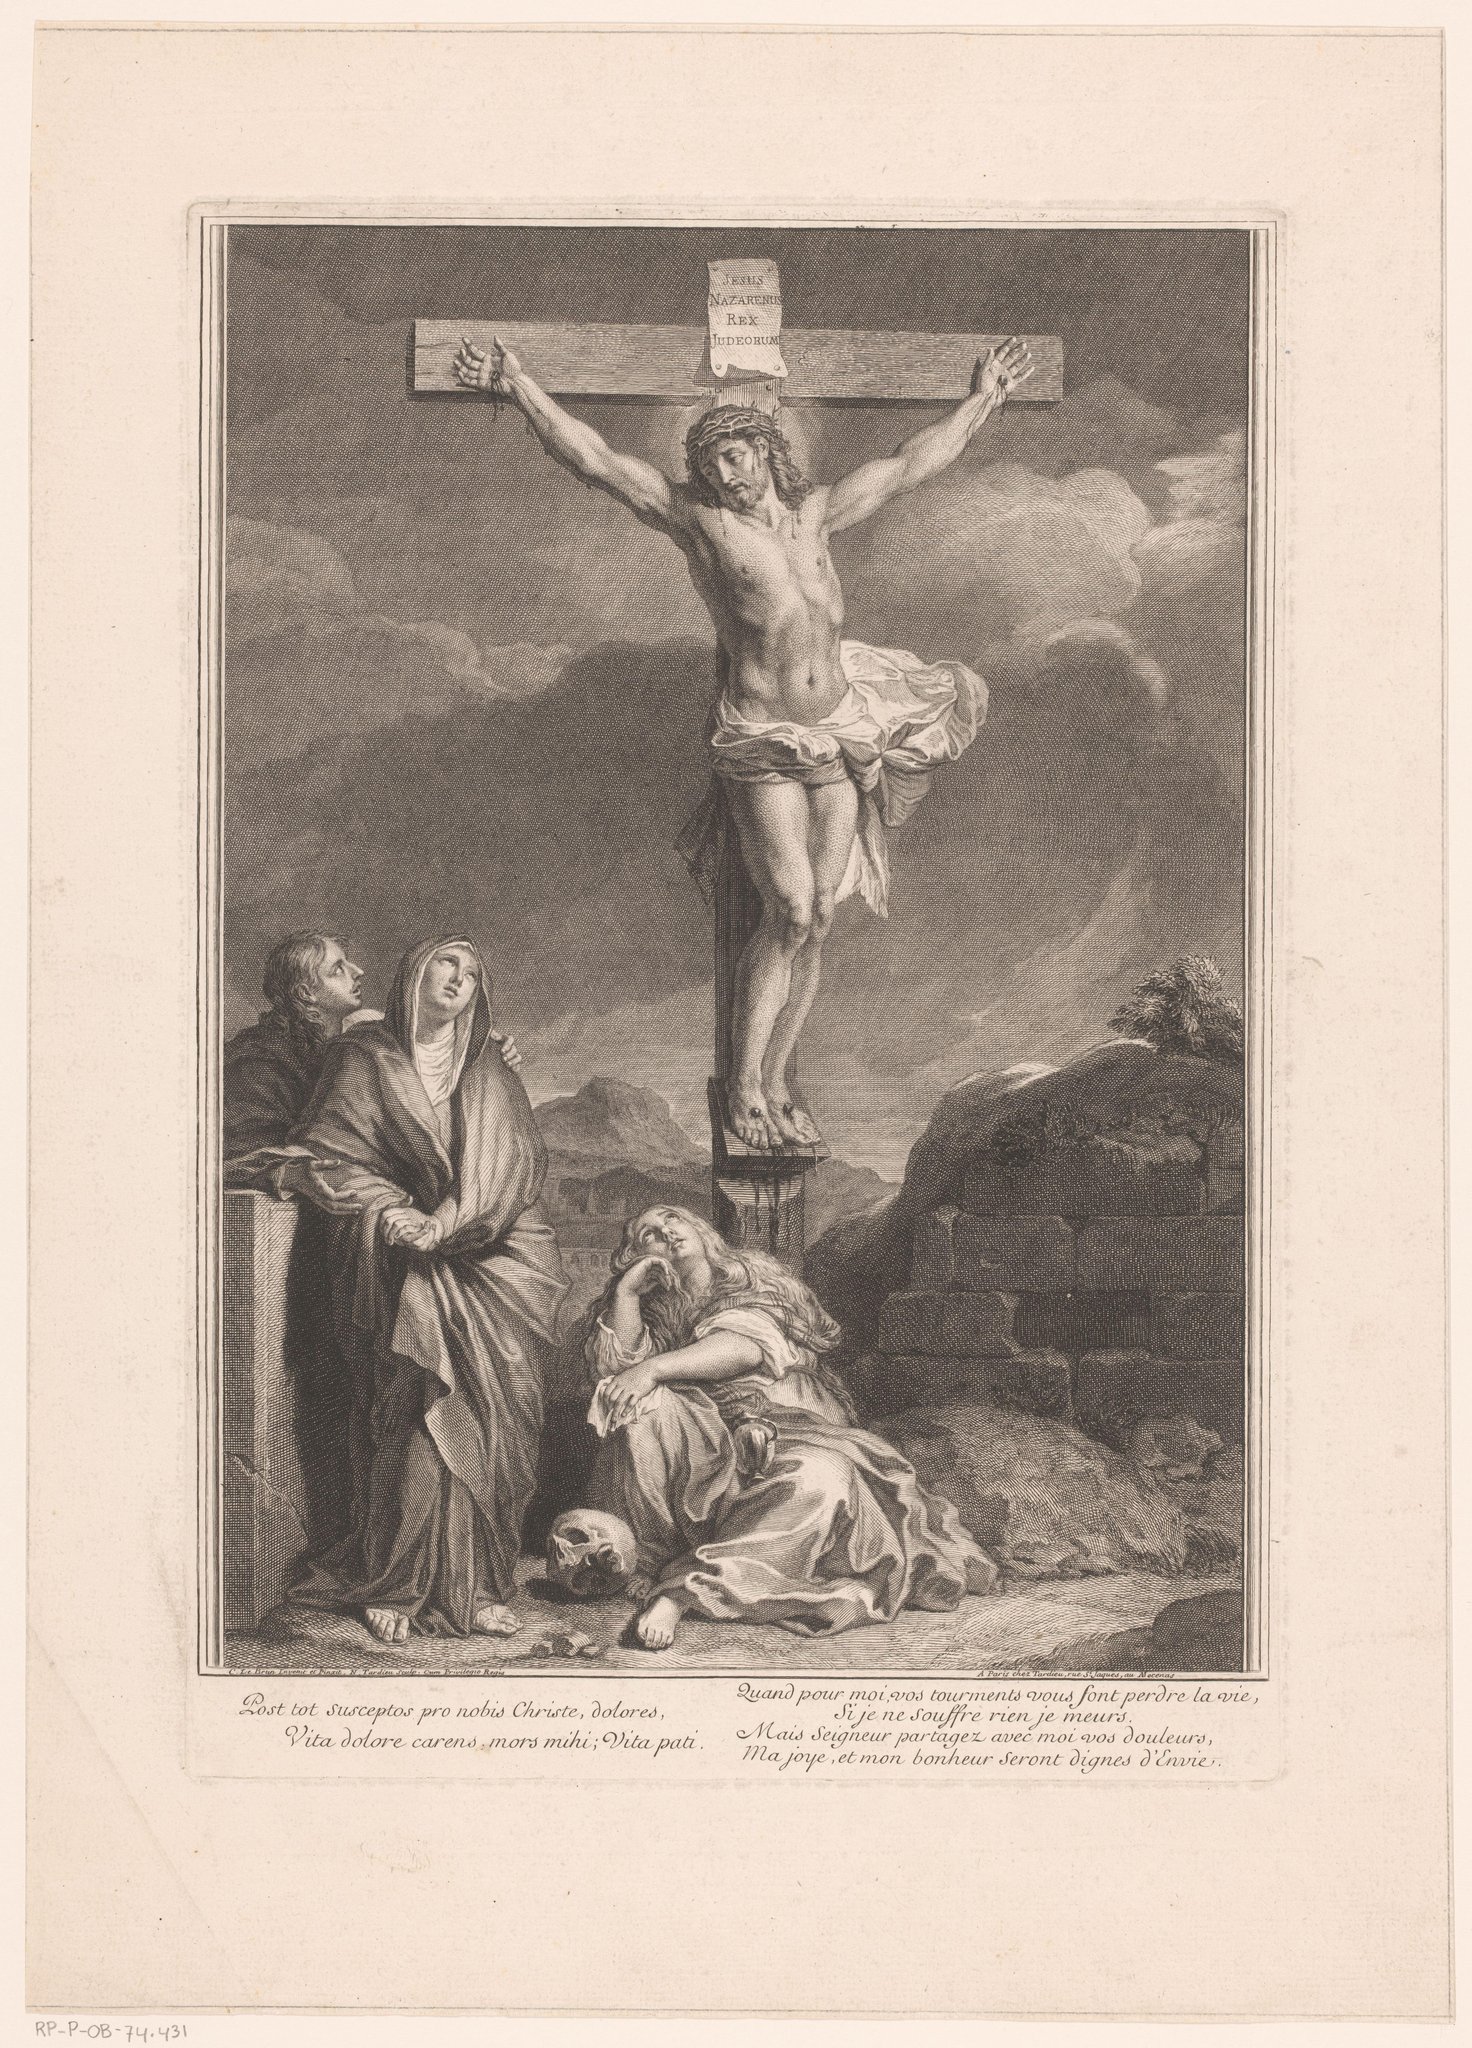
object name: print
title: Christus aan het kruis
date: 1684-1749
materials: paper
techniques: engraving, etching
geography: paris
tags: john the baptist; possible attributes: book, reed cross, baptismal cup, honeycomb, lamb, staff, bystanders at the foot of the cross, among whom mary, mary magdalene and john the evangelist; mary may be shown swooning - dd - only christ on the cross, the superscription: i(esus) n(azarenus) r(ex) i(udaeorum) ~ christ's crucifixion, the penitent harlot mary magdalene; possible attributes: book (or scroll), crown, crown of thorns, crucifix, jar of ointment, mirror, musical instrument, palm-branch, rosary, scourge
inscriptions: collector's mark: Lugt 240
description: Maria, Johannes en Maria Magdalena onder de gekruisigde Christus.